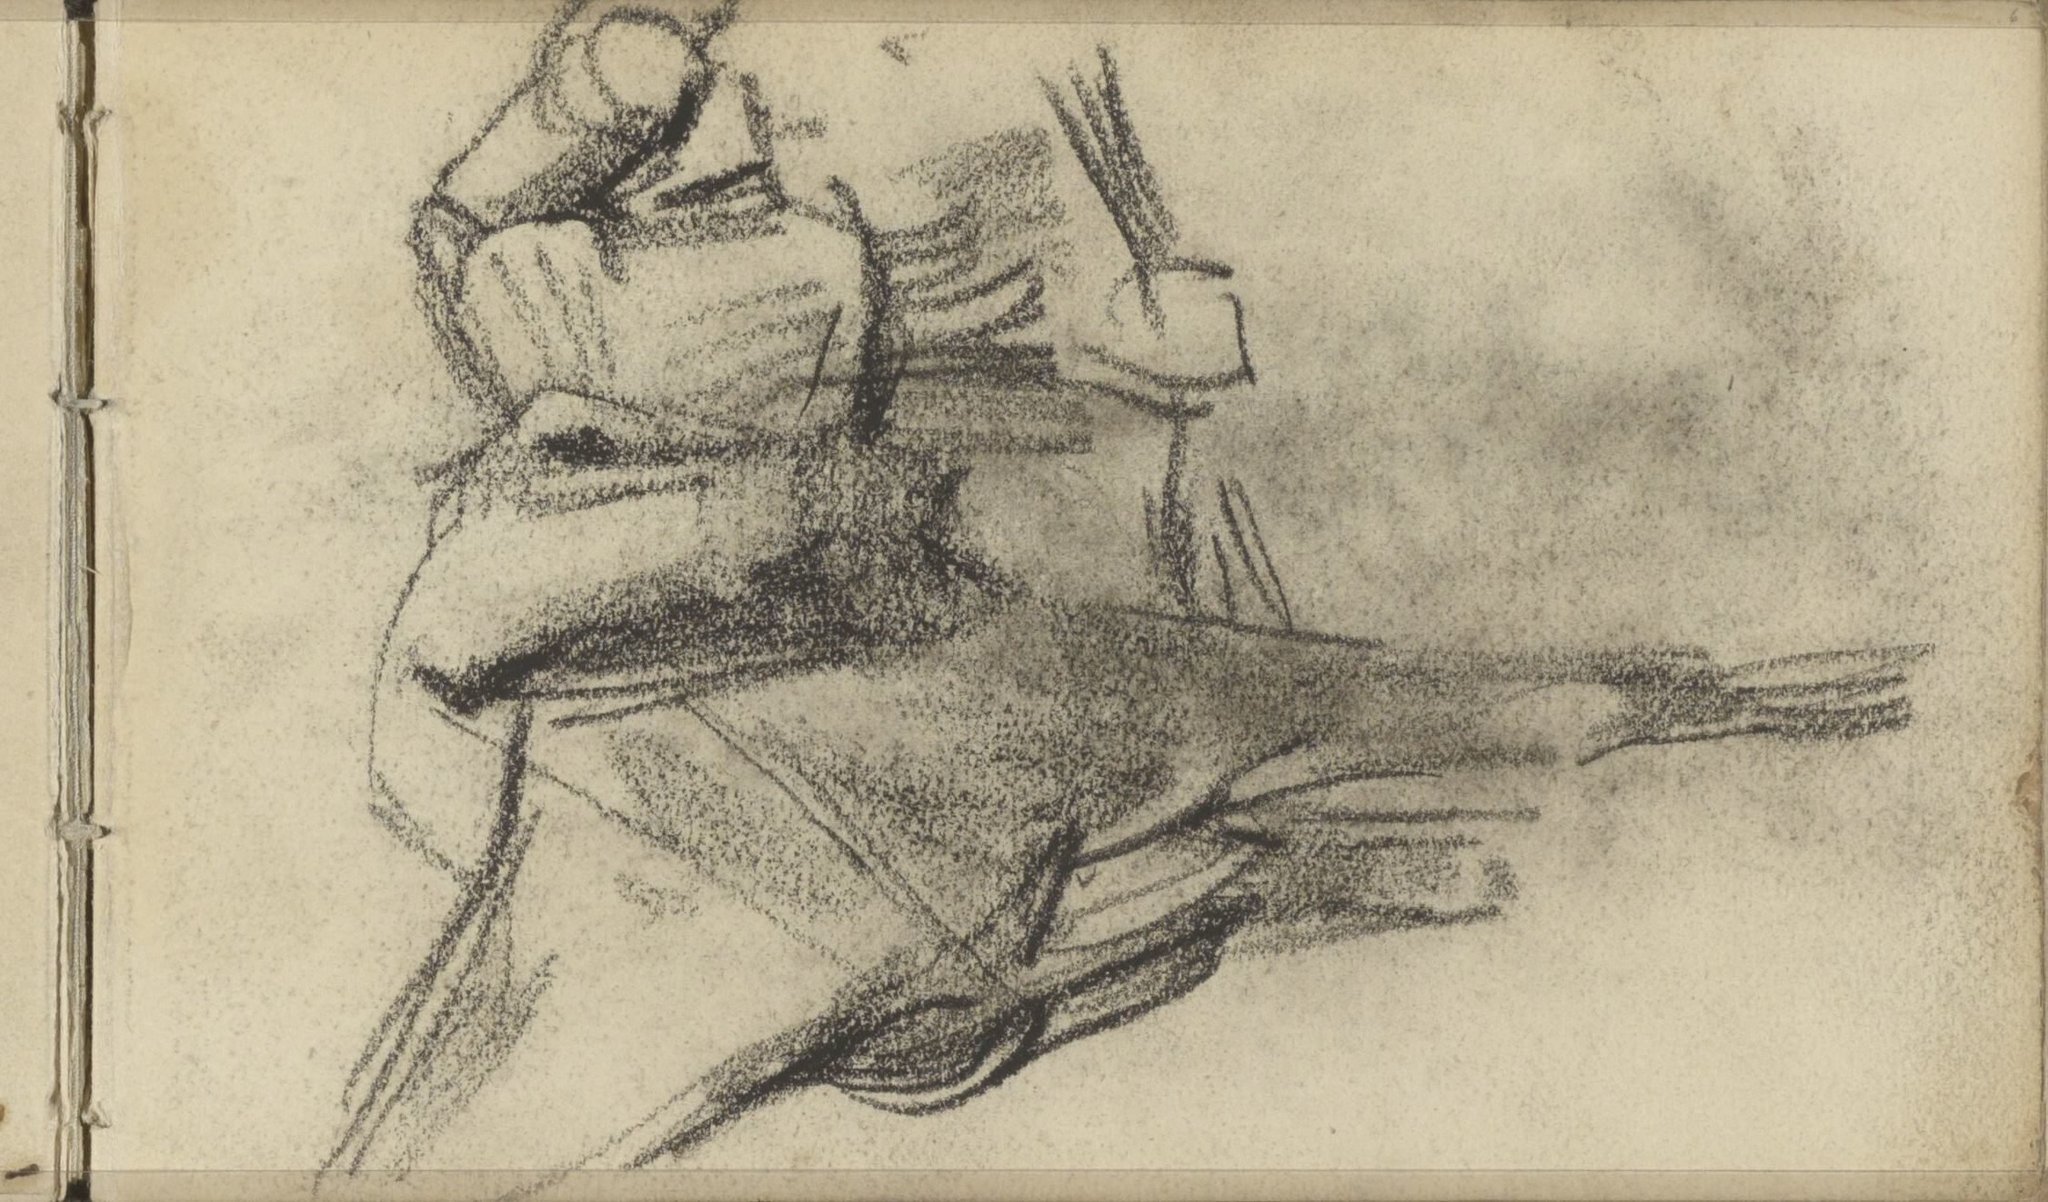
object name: sketchbook leaf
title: Paard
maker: george hendrik breitner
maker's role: draughtsman, painter, print maker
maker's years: 1857-1923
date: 1884-1886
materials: chalk, paper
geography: the hague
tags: horse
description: Pagina 6 uit een schetsboek met 35 bladen.